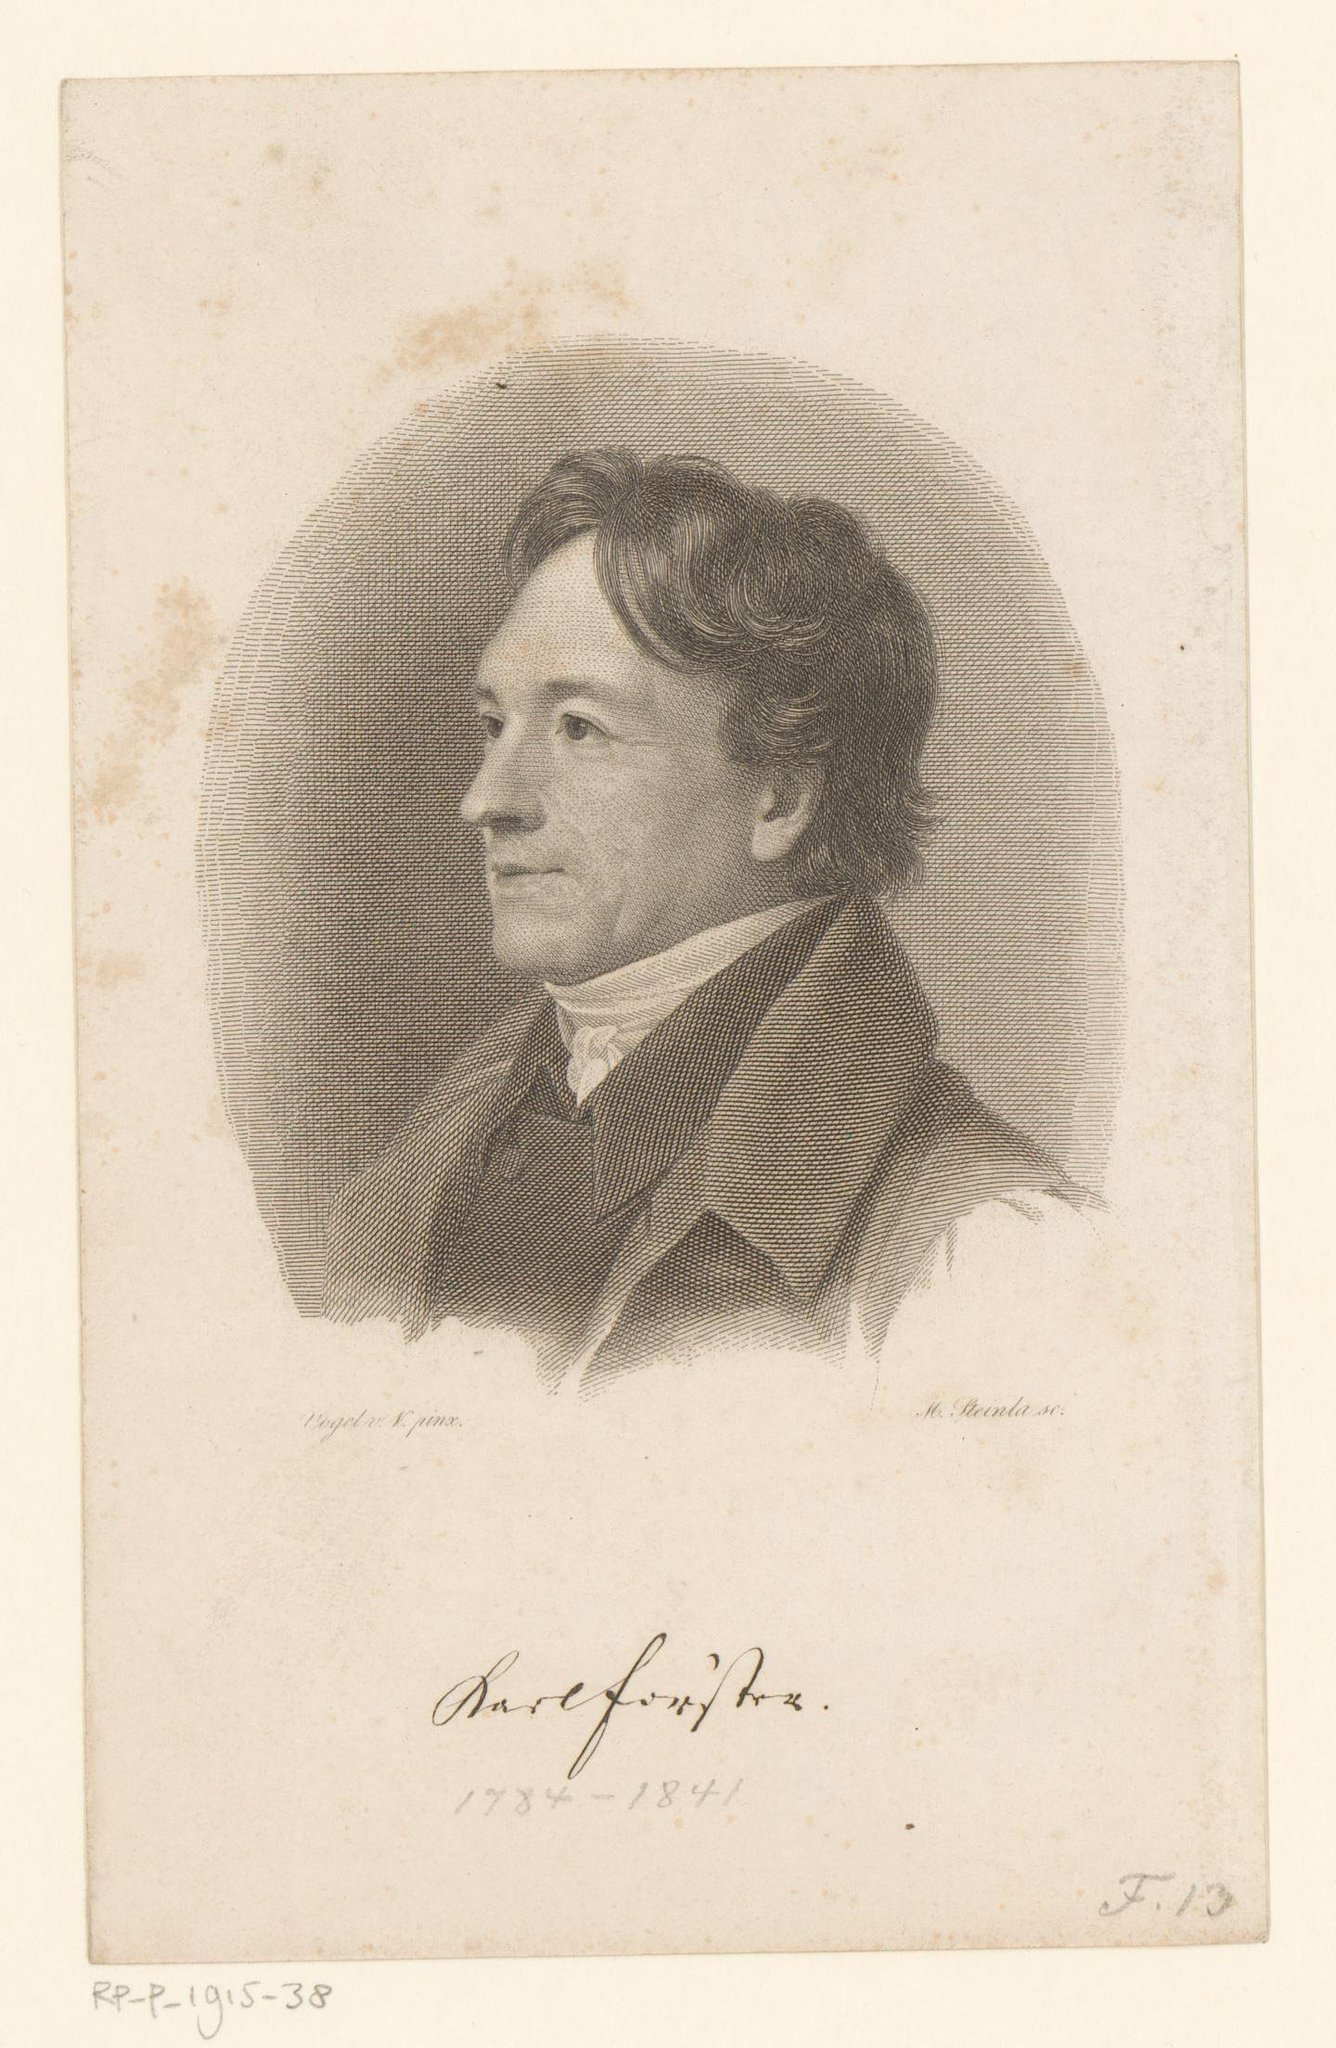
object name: print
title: Portret van Karl August Förster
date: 1815-1858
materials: paper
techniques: engraving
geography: germany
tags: historical persons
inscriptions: collector's mark: Lugt 2228